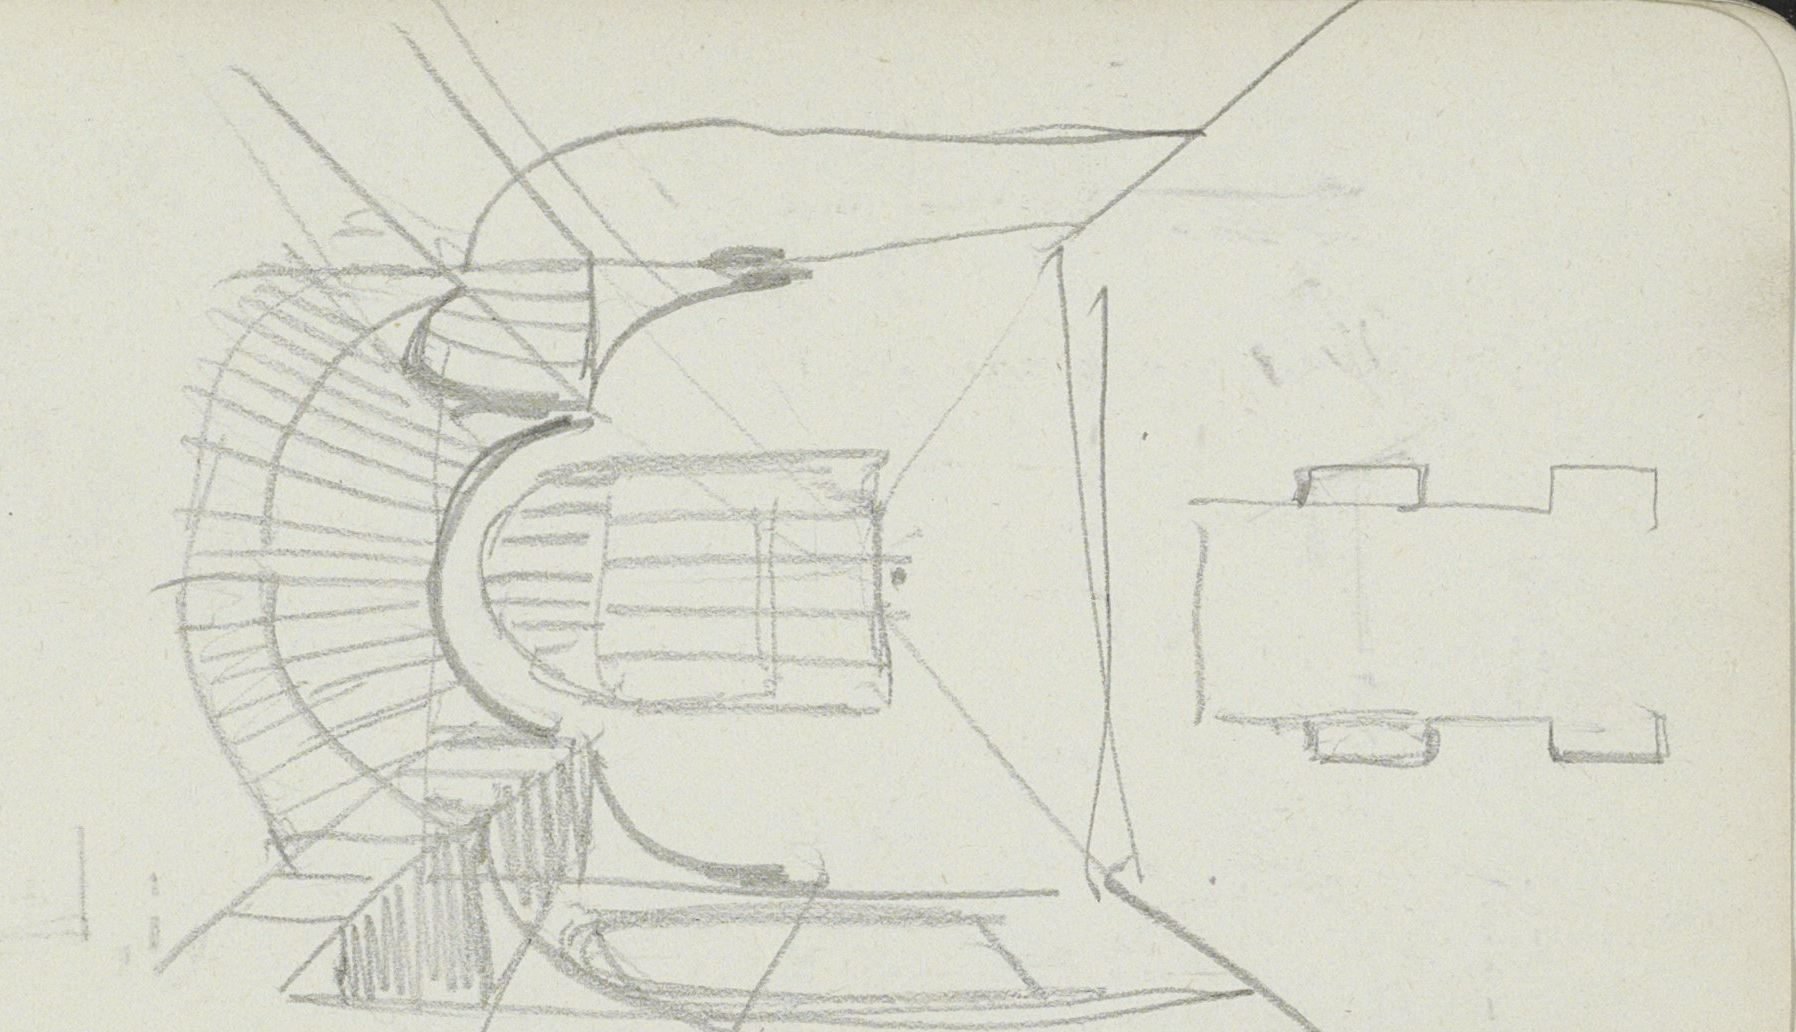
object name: sketchbook leaf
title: Kerkinterieur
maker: carel adolph lion cachet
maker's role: draughtsman, print maker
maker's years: 1864-1945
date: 1905-1906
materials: paper, pencil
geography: vreeland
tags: interior of church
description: Blad 28 recto uit een schetsboek met 34 bladen.